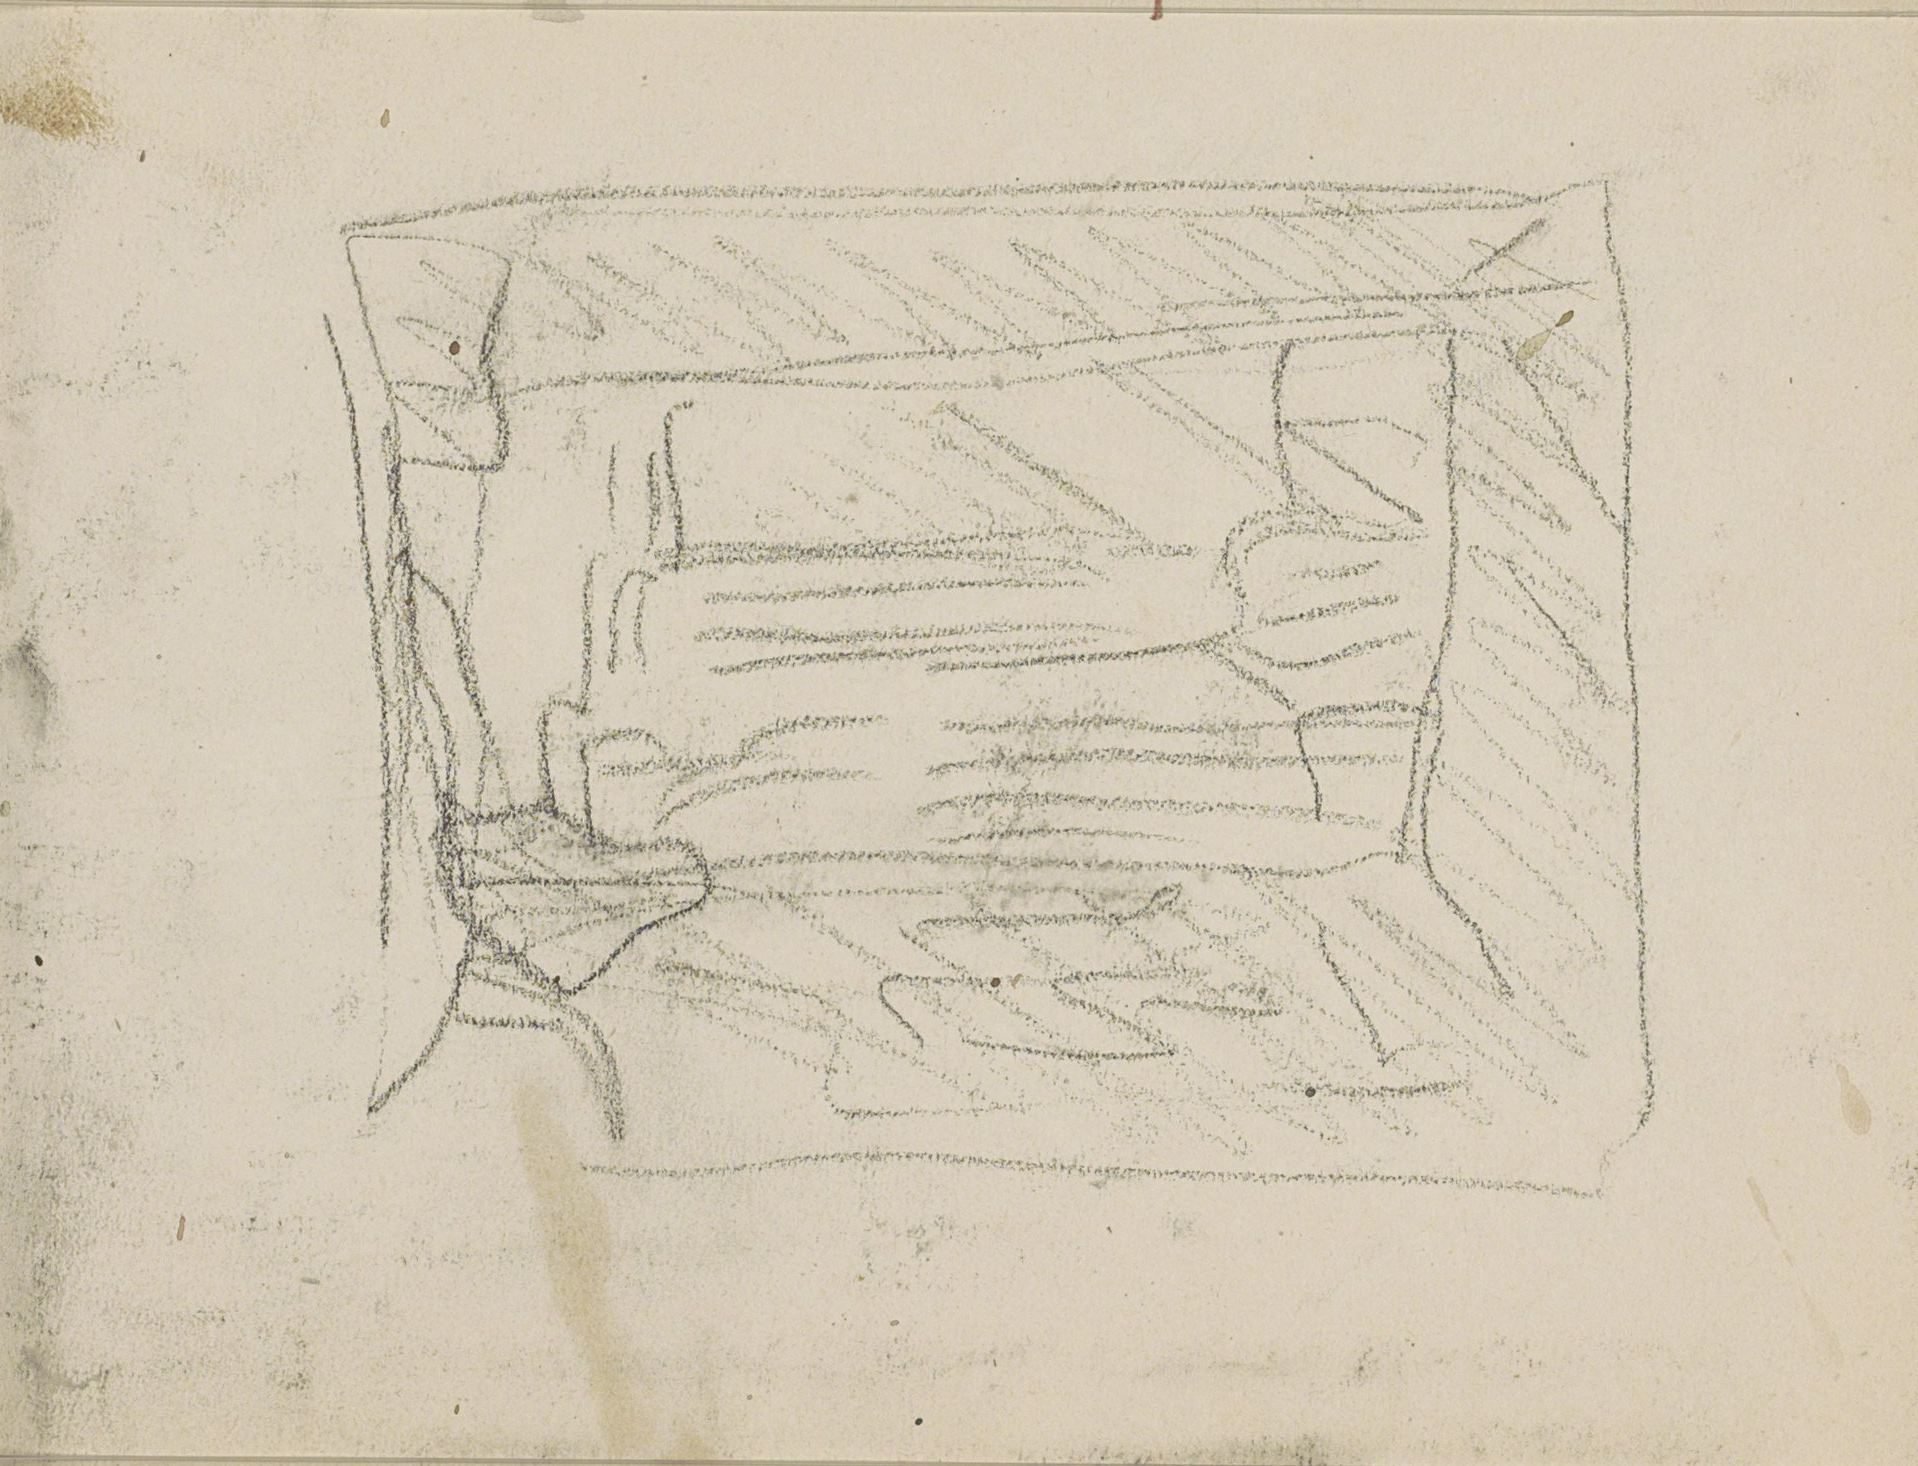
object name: sketchbook leaf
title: Interieur van de Luxortempel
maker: marius bauer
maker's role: draughtsman, print maker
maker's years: 1867-1932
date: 1919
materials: chalk, paper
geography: luxor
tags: temple, shrine ~ egyptian religion, sitting figure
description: Op de grond bij ee zuil zit een figuur. Pagina 44 uit een schetsboek met 28 bladen.